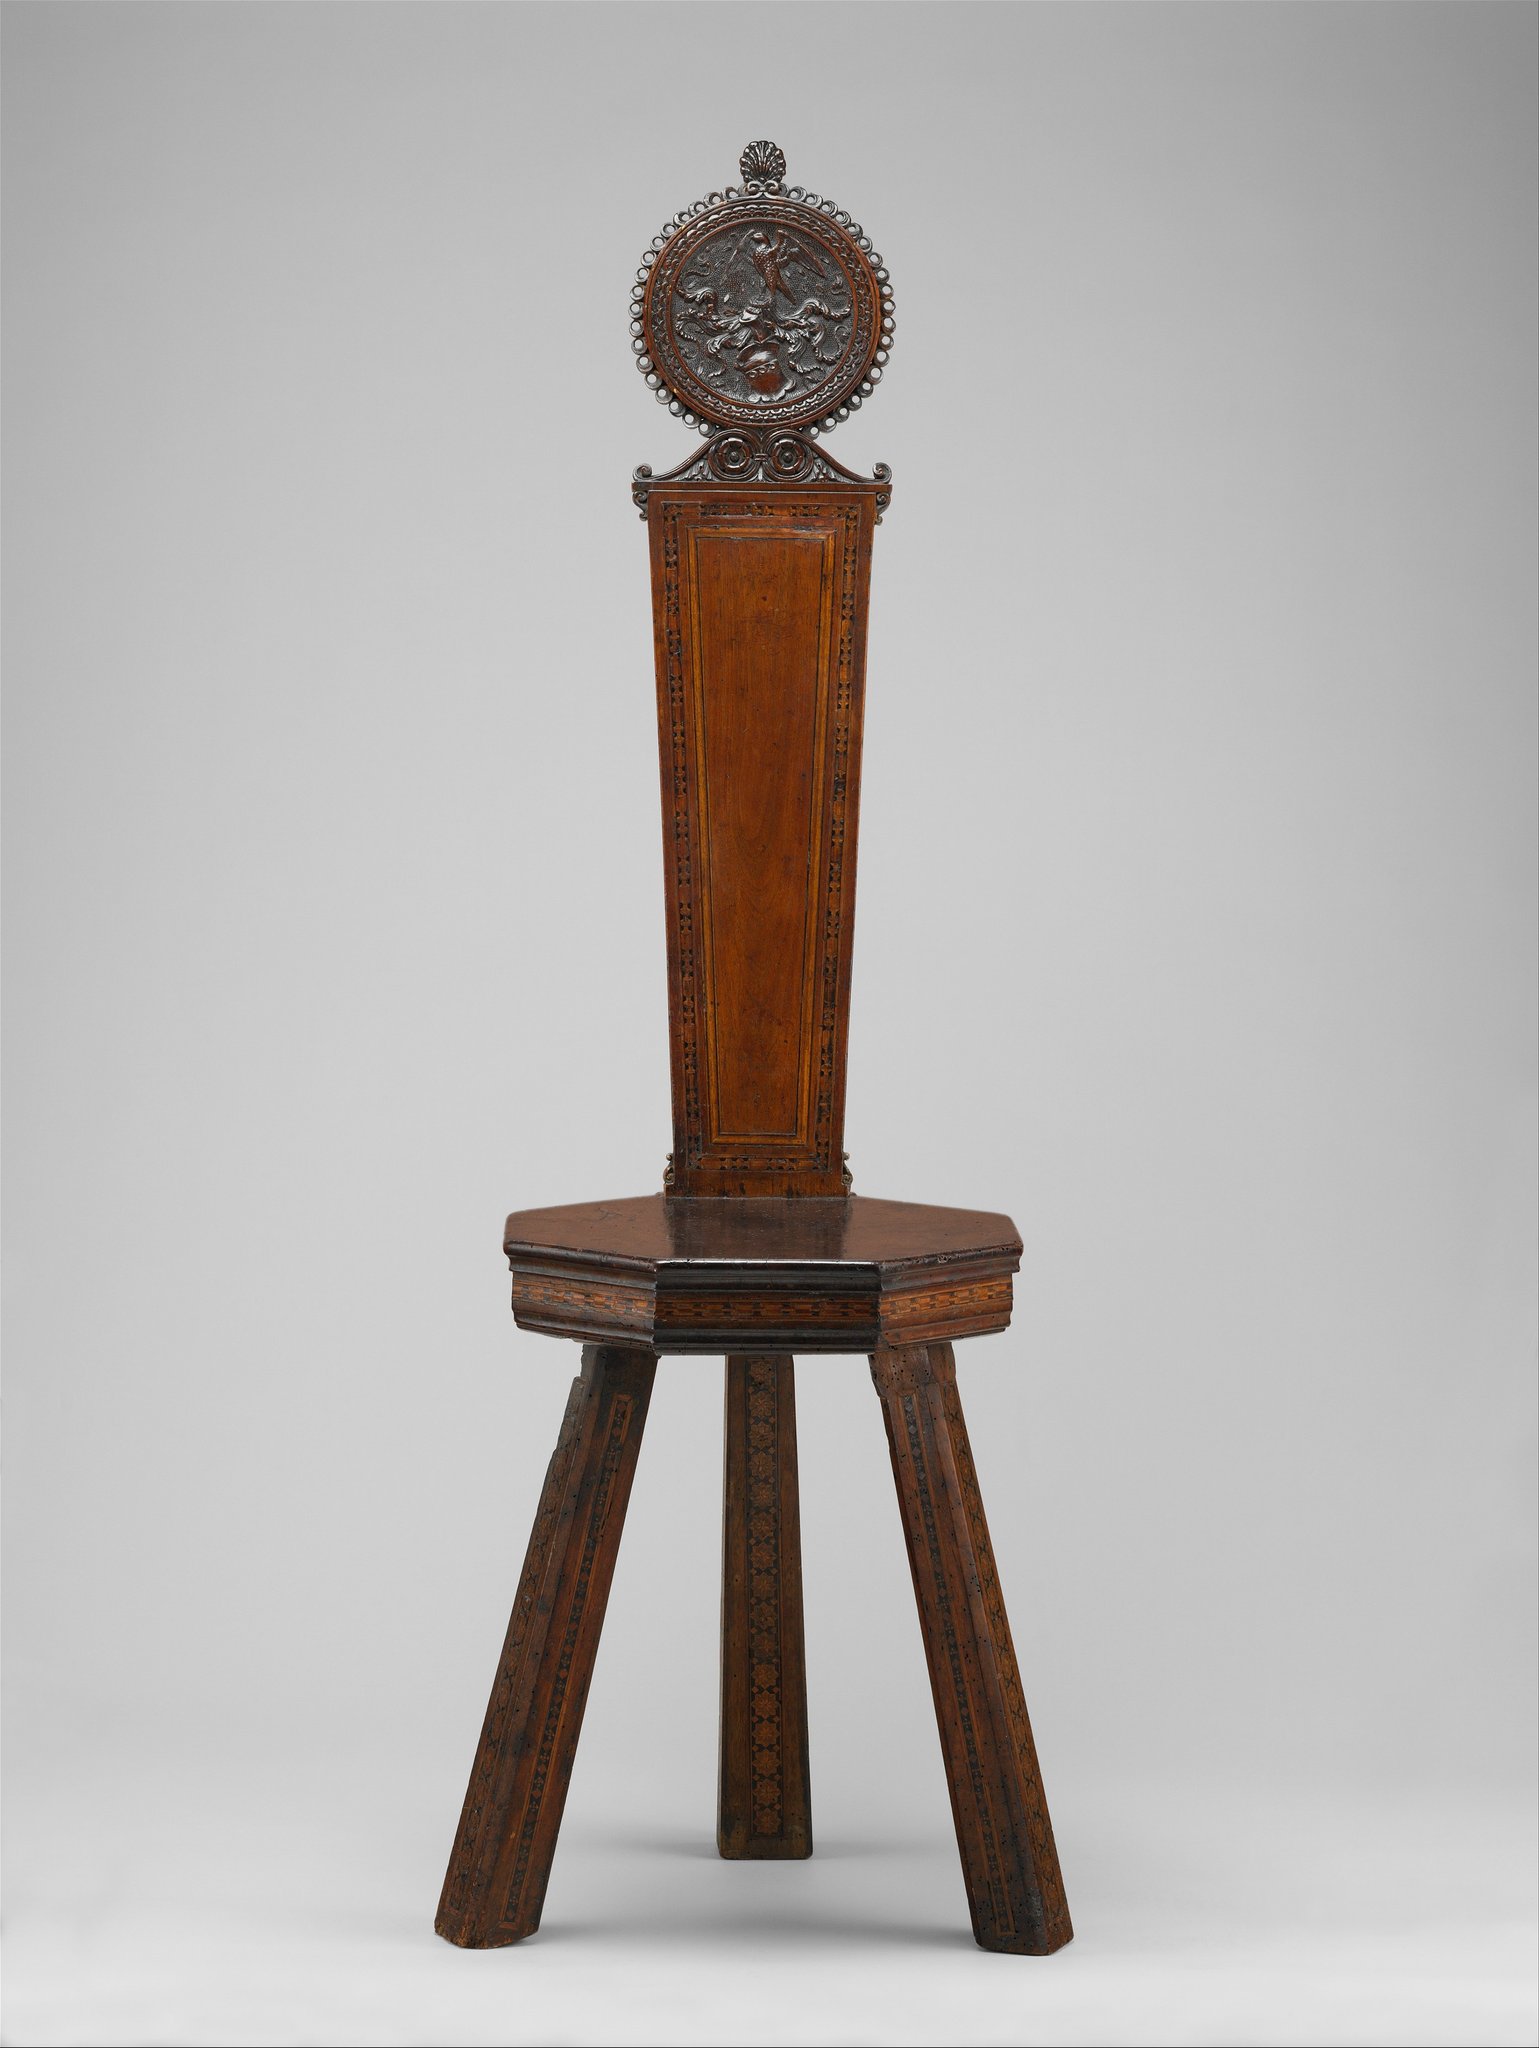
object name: chair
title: Chair (Sgabello)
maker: workshop of giuliano da maiano (1432–1490) and benedetto da maiano (1442–1497)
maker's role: maker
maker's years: 1432-1497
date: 1489-1491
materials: wood, paint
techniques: gilding